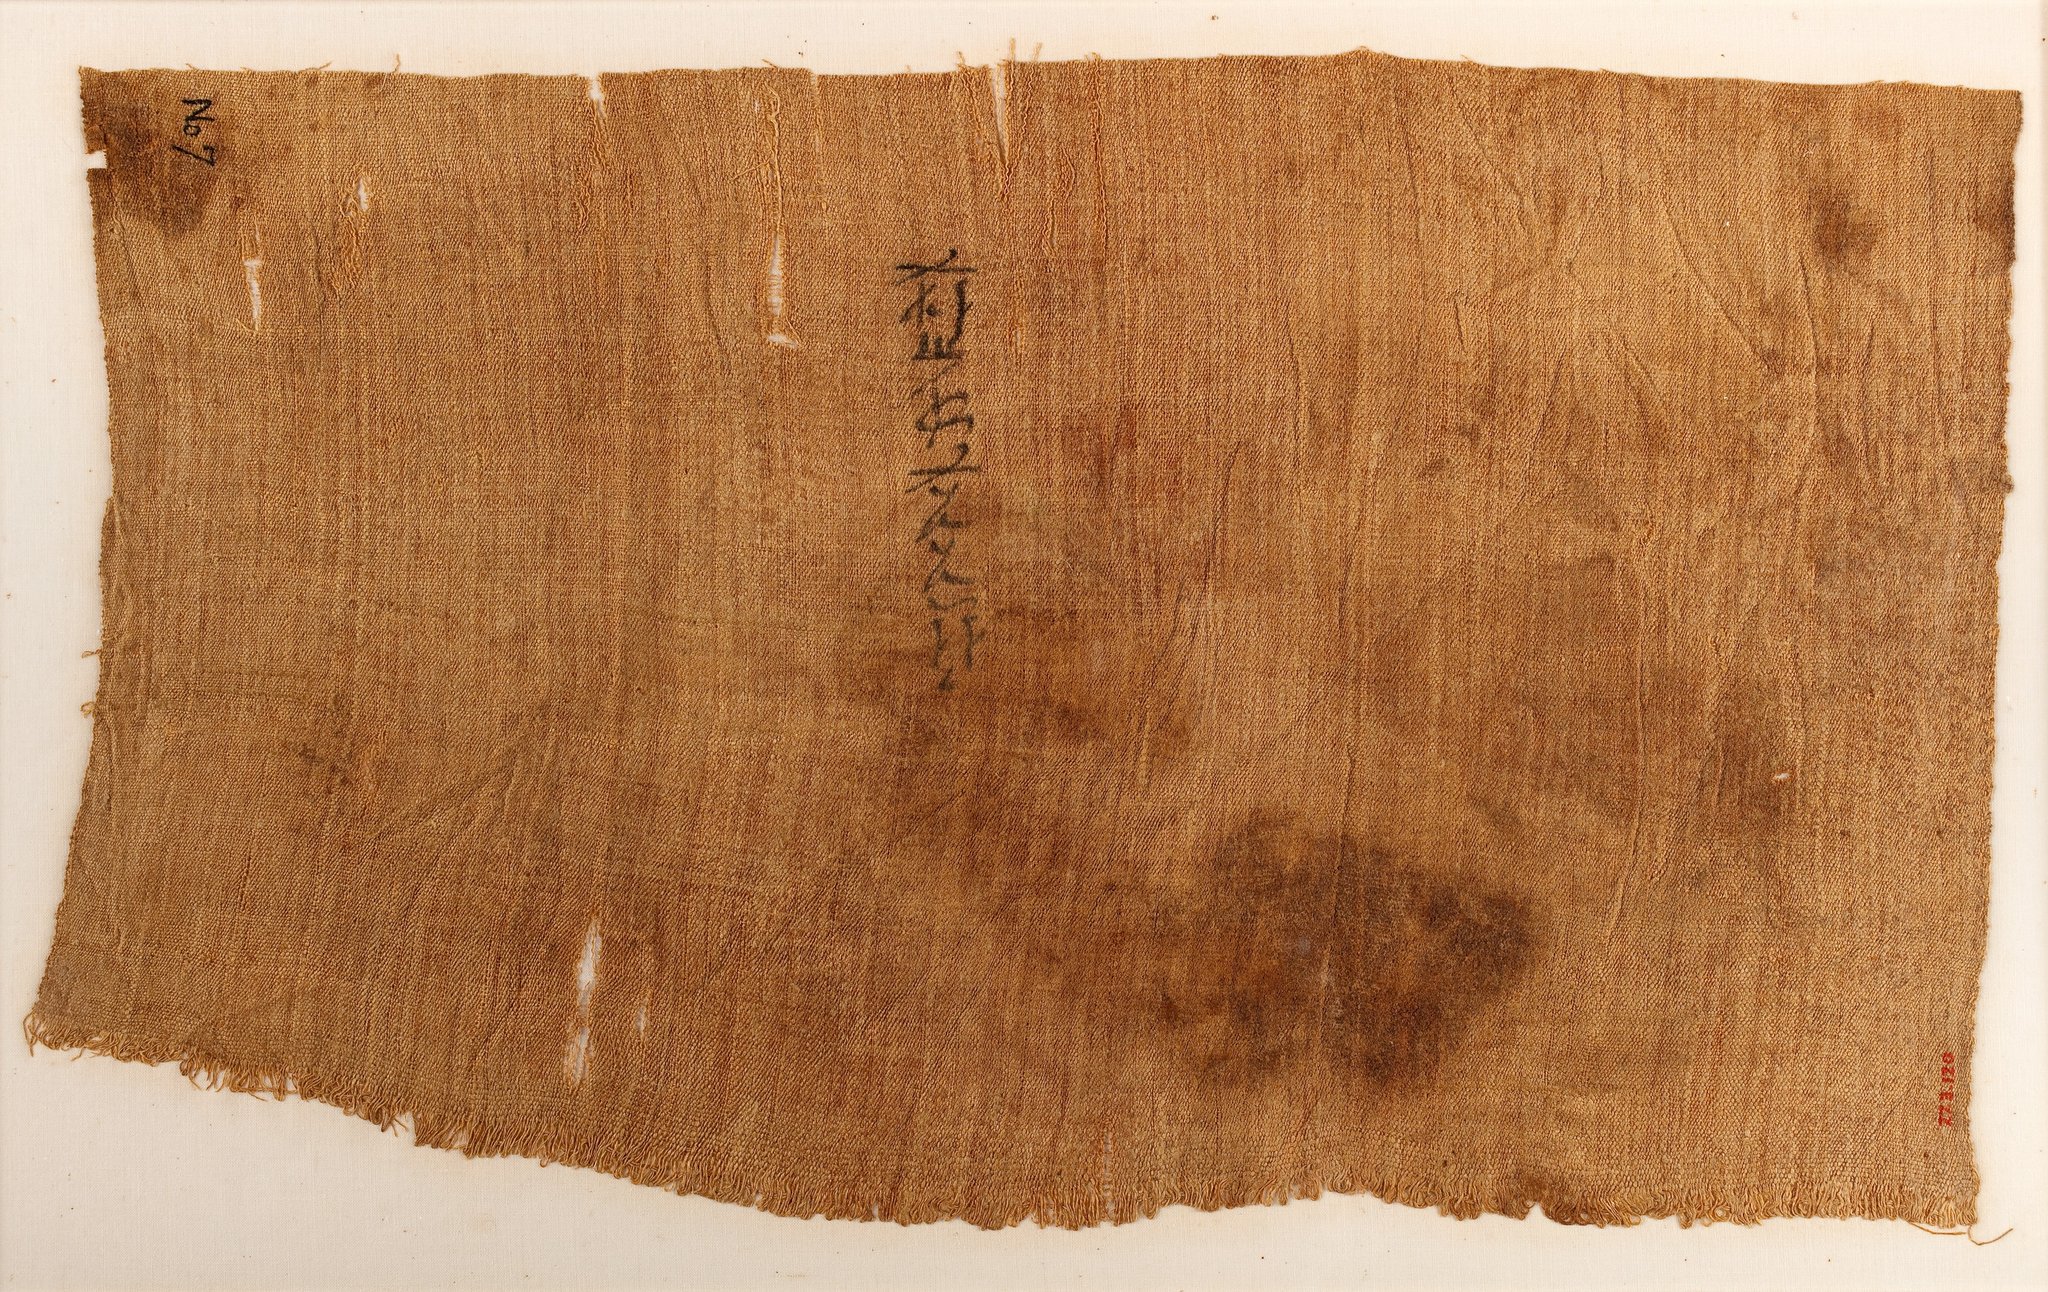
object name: linen mark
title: Linen mark (Type XXI)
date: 1961-1917 BCE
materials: linen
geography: egypt